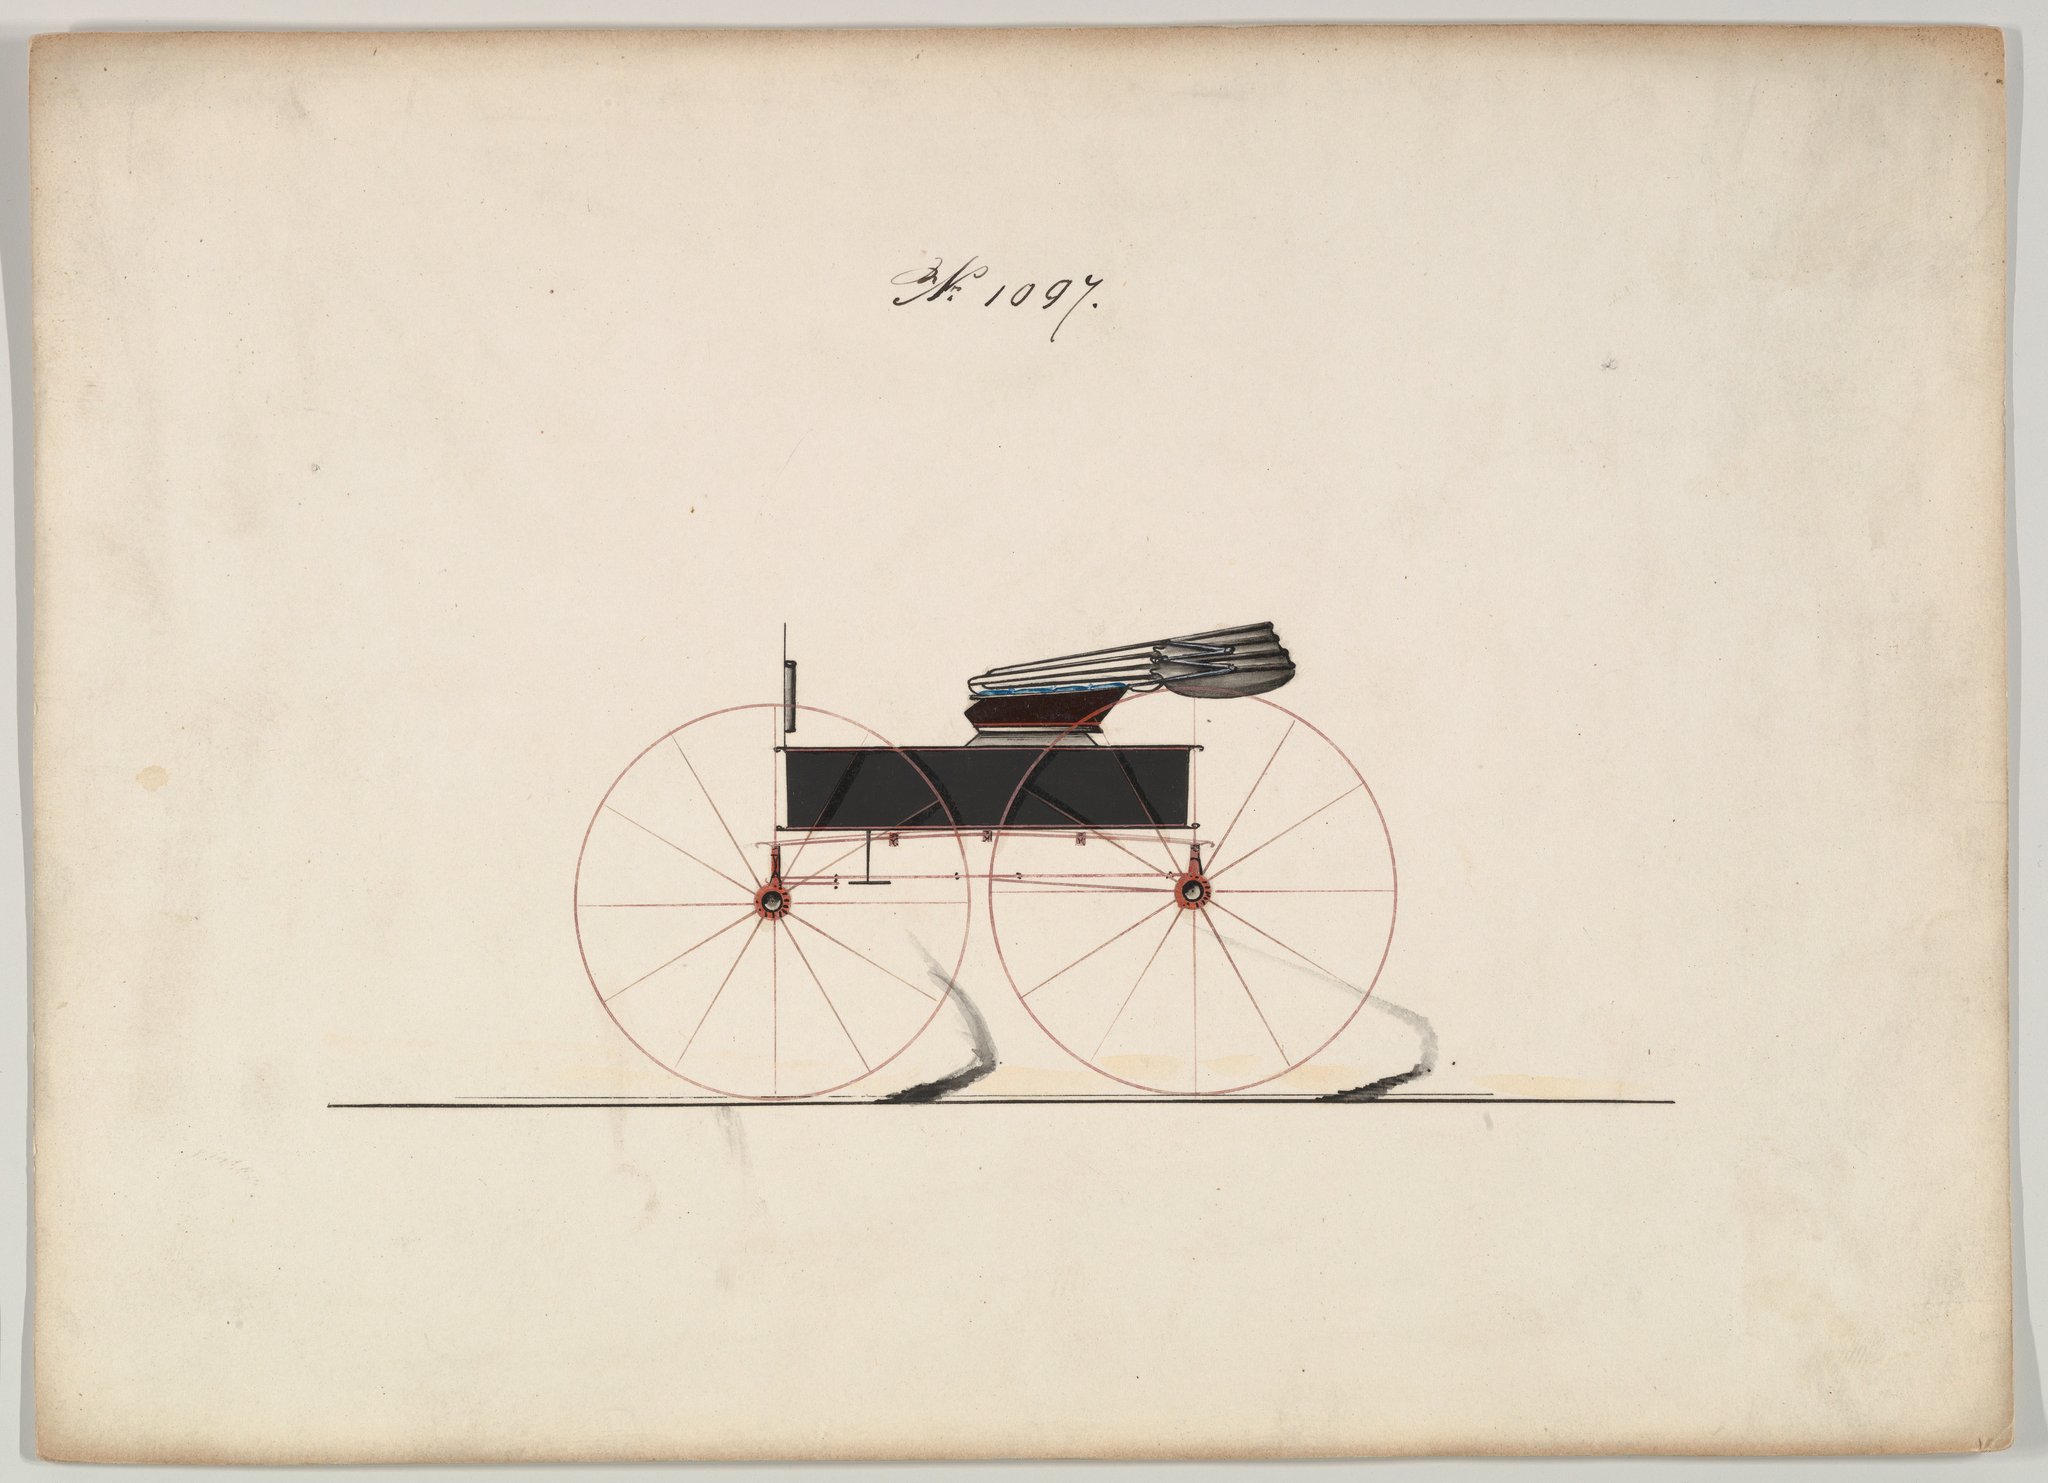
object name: drawing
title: Design for Wagon, no. 1097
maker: brewster & co.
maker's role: manufacturer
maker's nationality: american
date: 1850-1870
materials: gum arabic, ink, watercolor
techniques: pen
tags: carriages